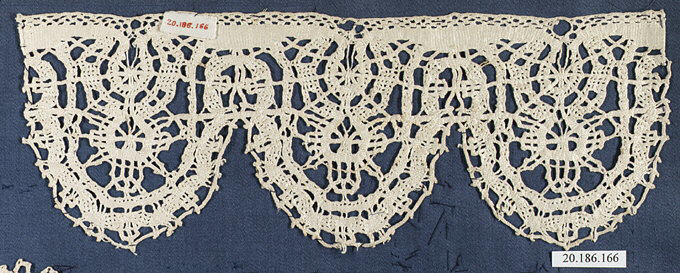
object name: edging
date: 1601-1700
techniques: lace